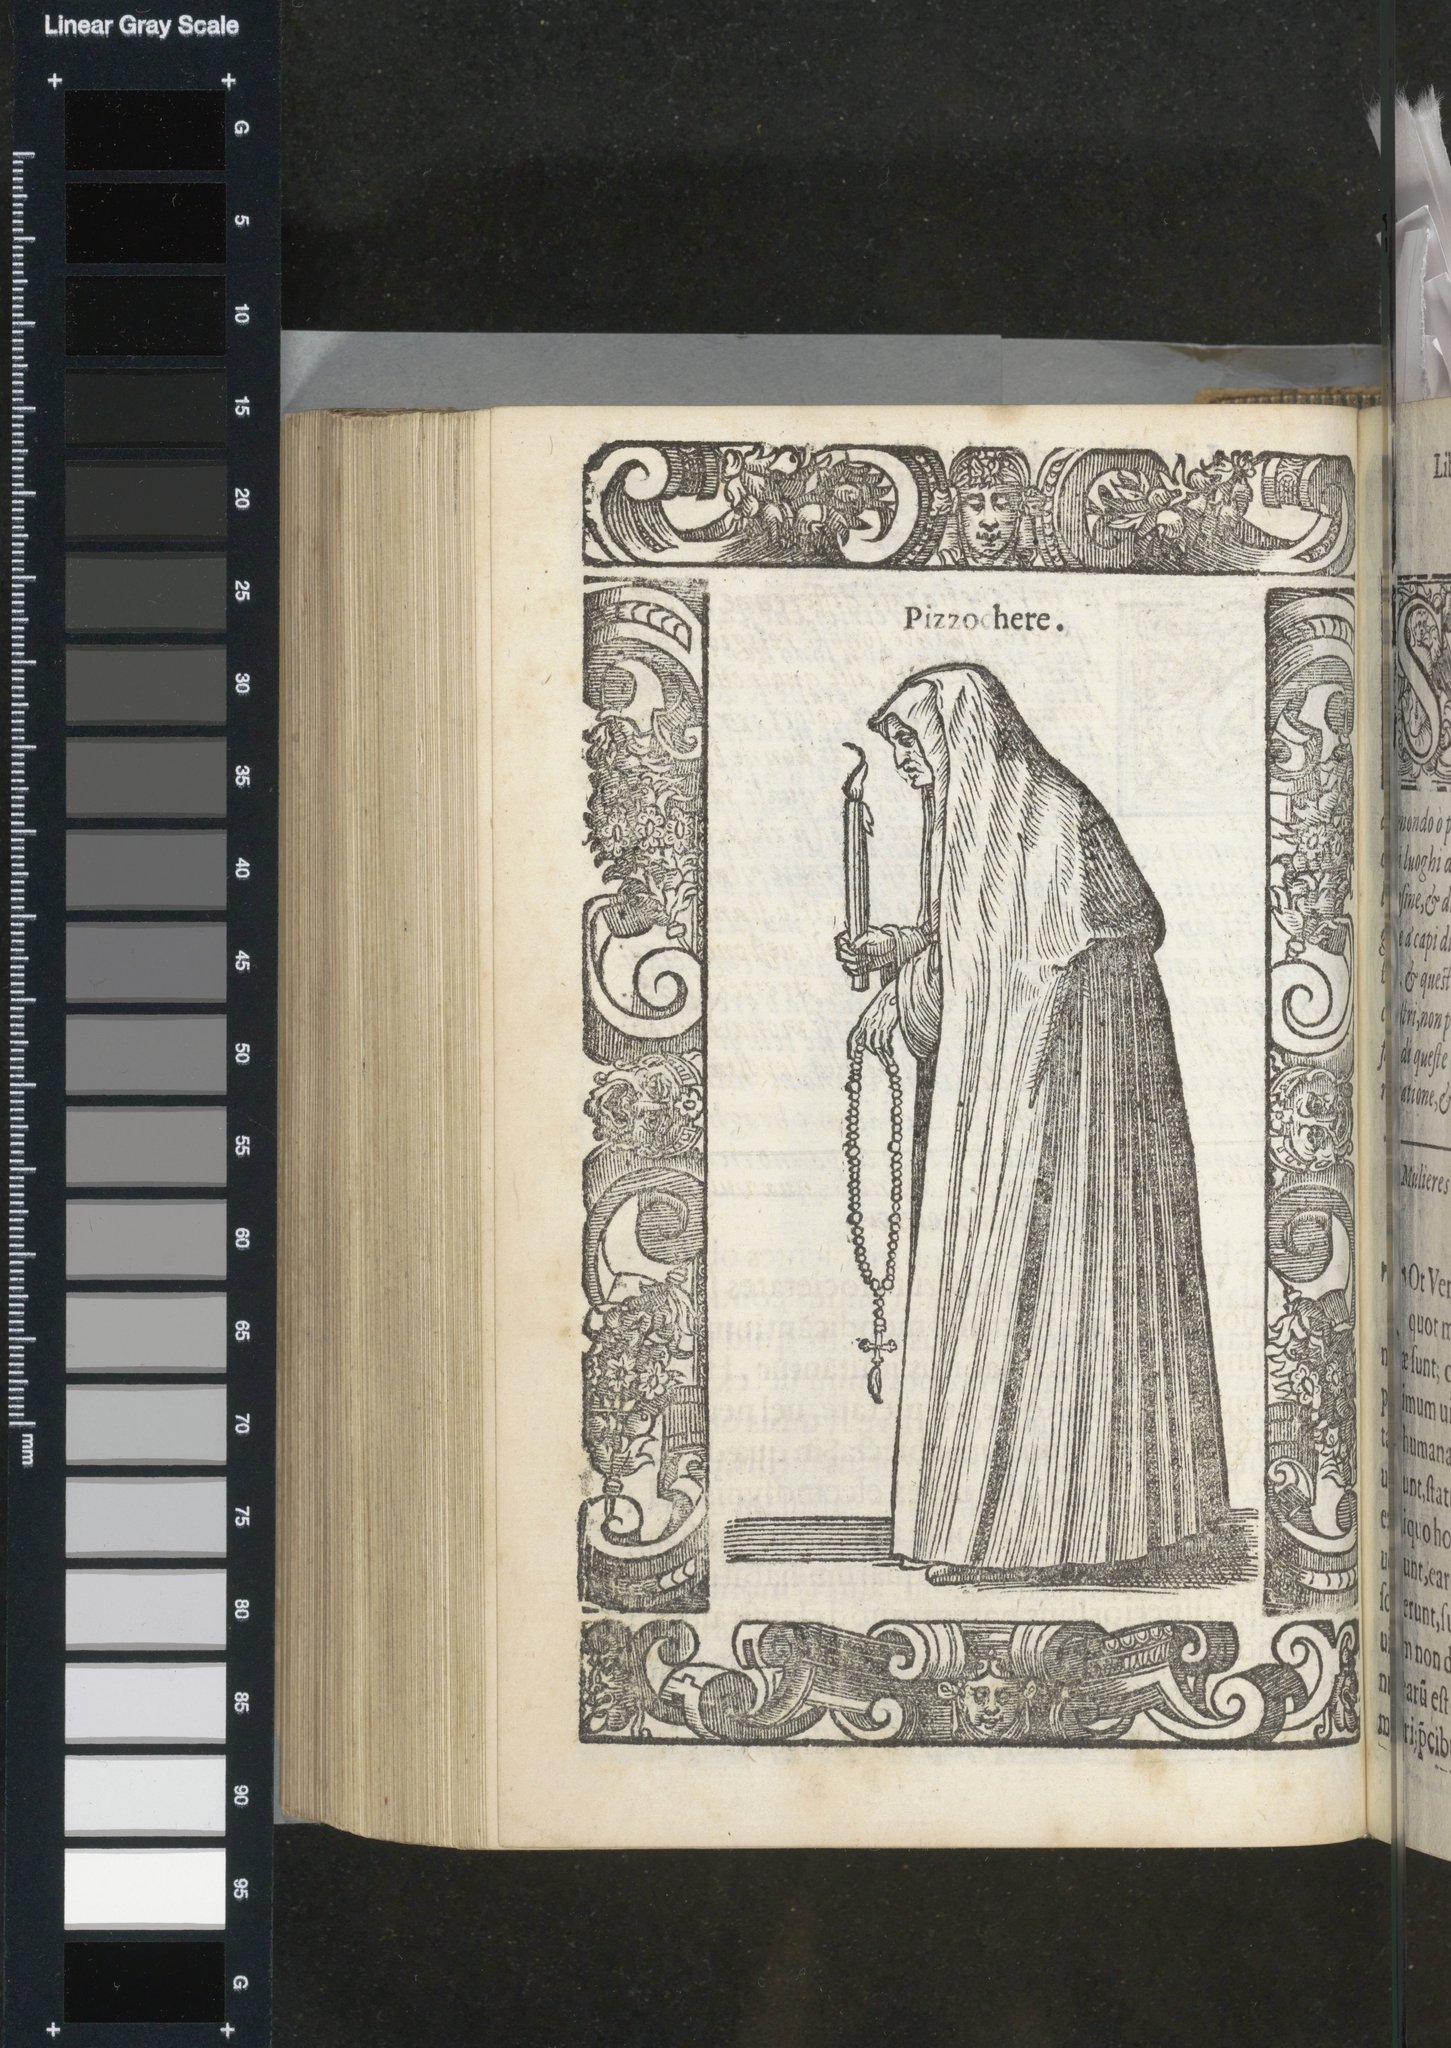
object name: costume print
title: Pizzochere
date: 1598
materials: paper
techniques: woodcut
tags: nun(s), cape (+ women's clothes), aids for prayer, e.g. rosary, fashion plates, candle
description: Oudere vrouw in wijde schoudermantel die over het hoofd naar beneden valt. Rozenkrans en brandende kaars in de hand. In ornamentrand